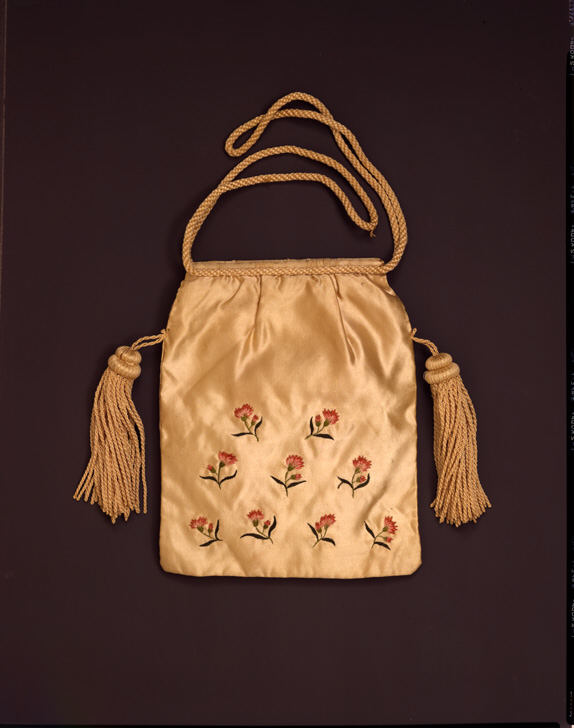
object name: purse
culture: american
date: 1836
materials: silk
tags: flowers